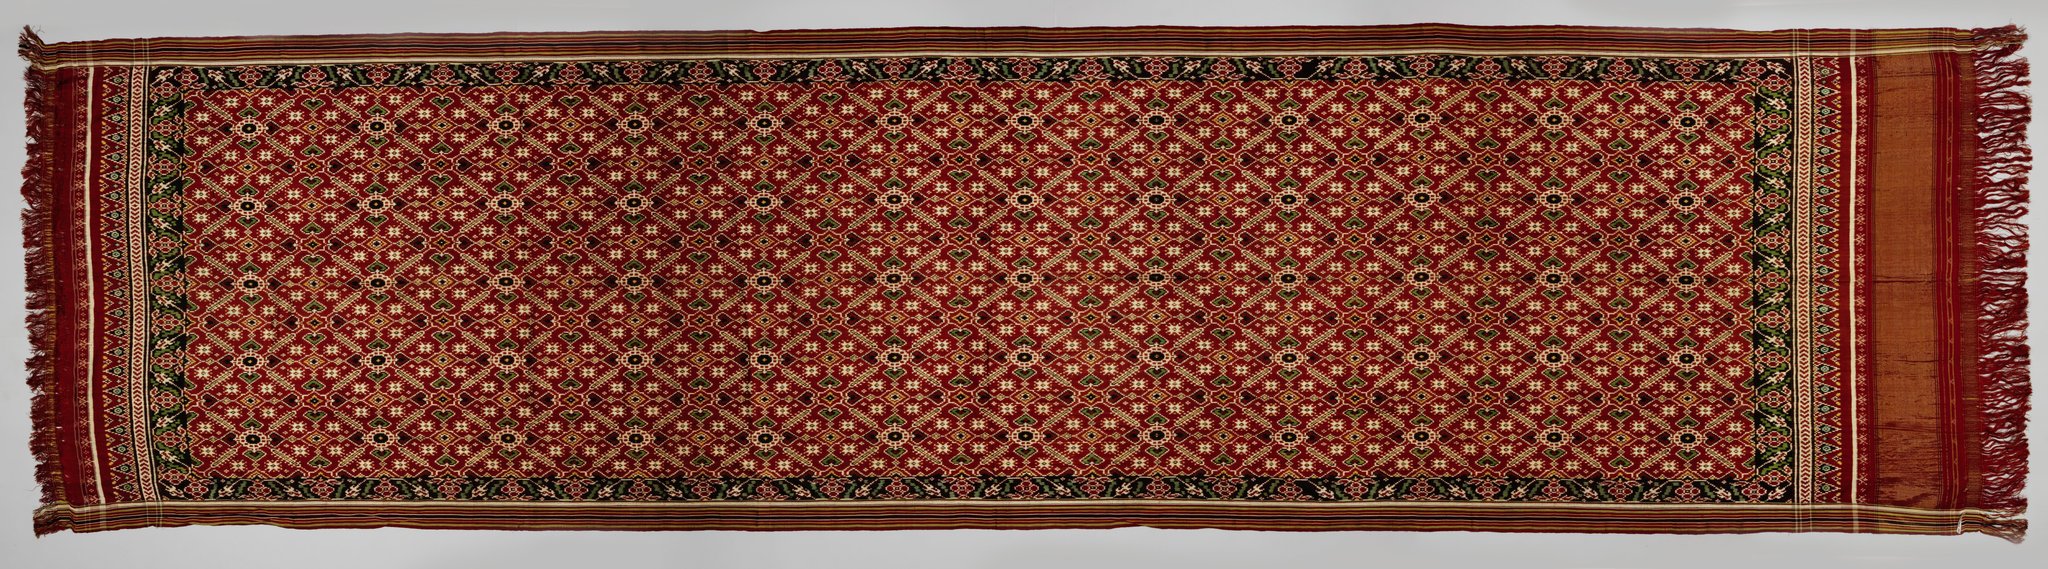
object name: omslagdoek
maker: Anonymous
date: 1900-1949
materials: silk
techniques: weave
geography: india